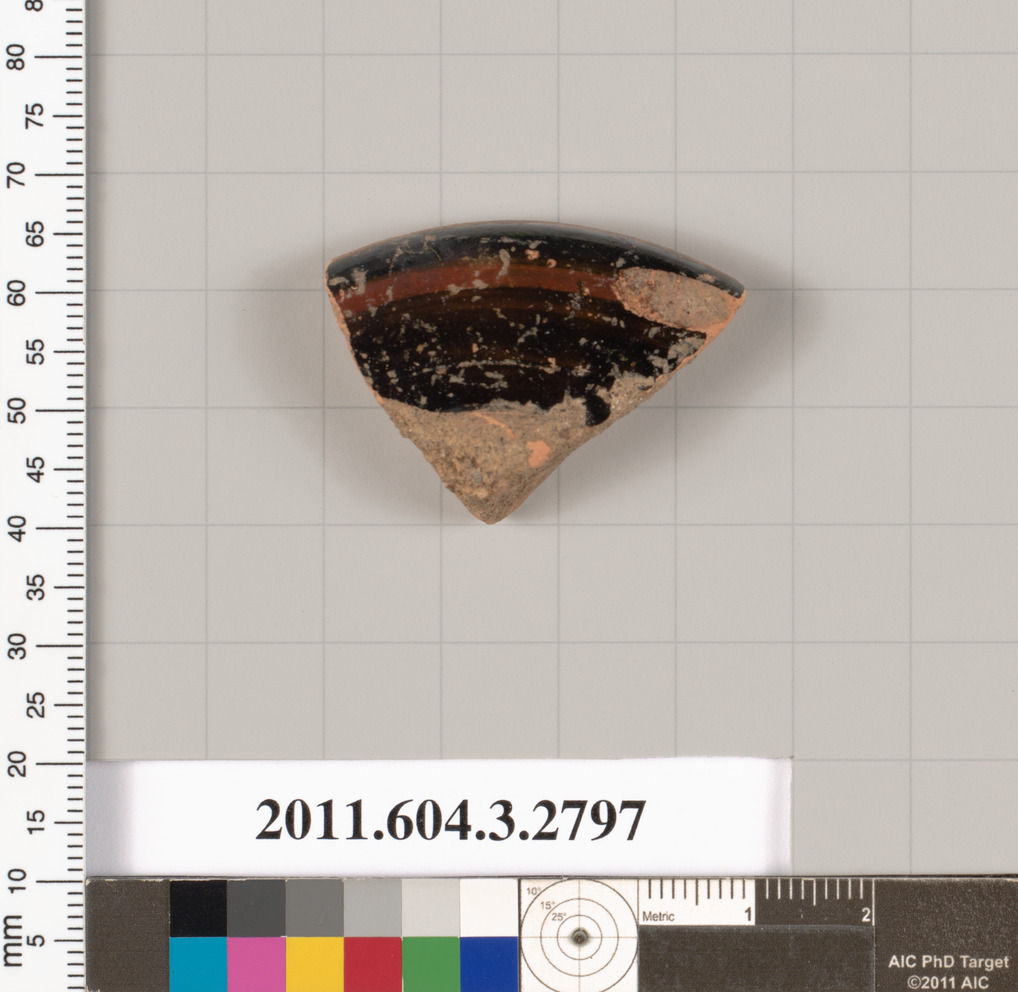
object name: oinochoe or olpe fragment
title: Terracotta fragment of an oinochoe (jug) or olpe (jug)?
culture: greek, attic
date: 600-401 BCE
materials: terracotta